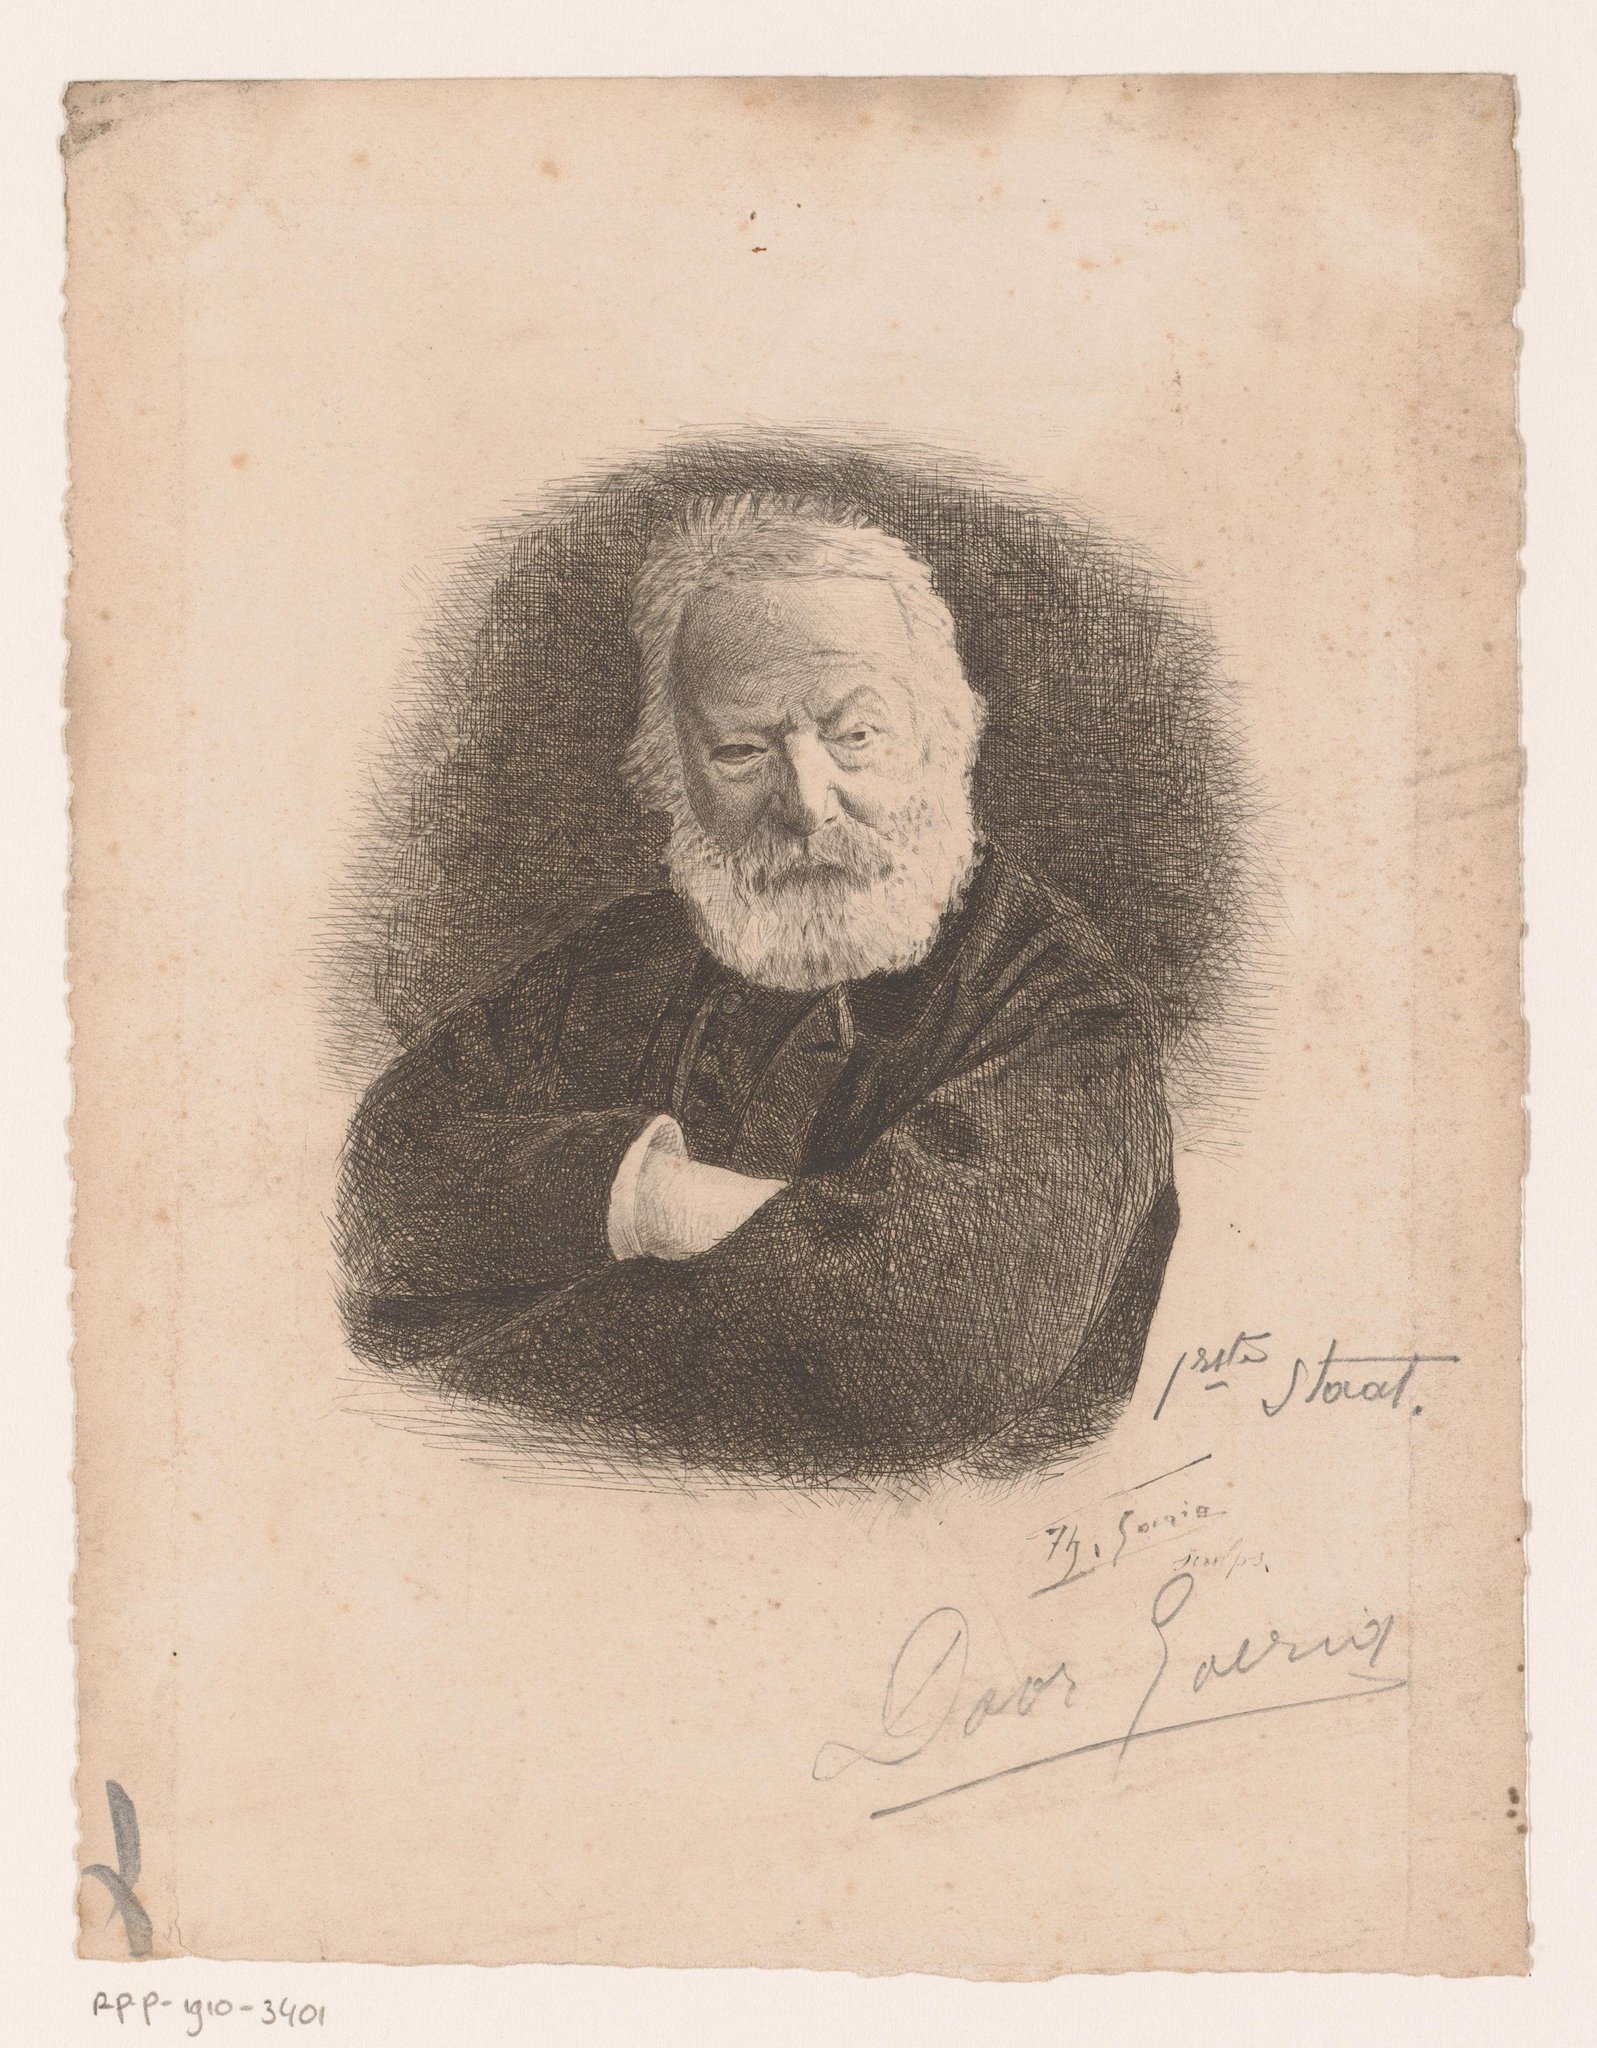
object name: print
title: Portret van Victor Hugo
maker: david goerig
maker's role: print maker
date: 1850-1899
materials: paper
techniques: etching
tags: paris, victor hugo, historical persons, old man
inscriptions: collector's mark: Lugt 2228, inscription: ‘1 sts staat; (...) Goerig sculps’